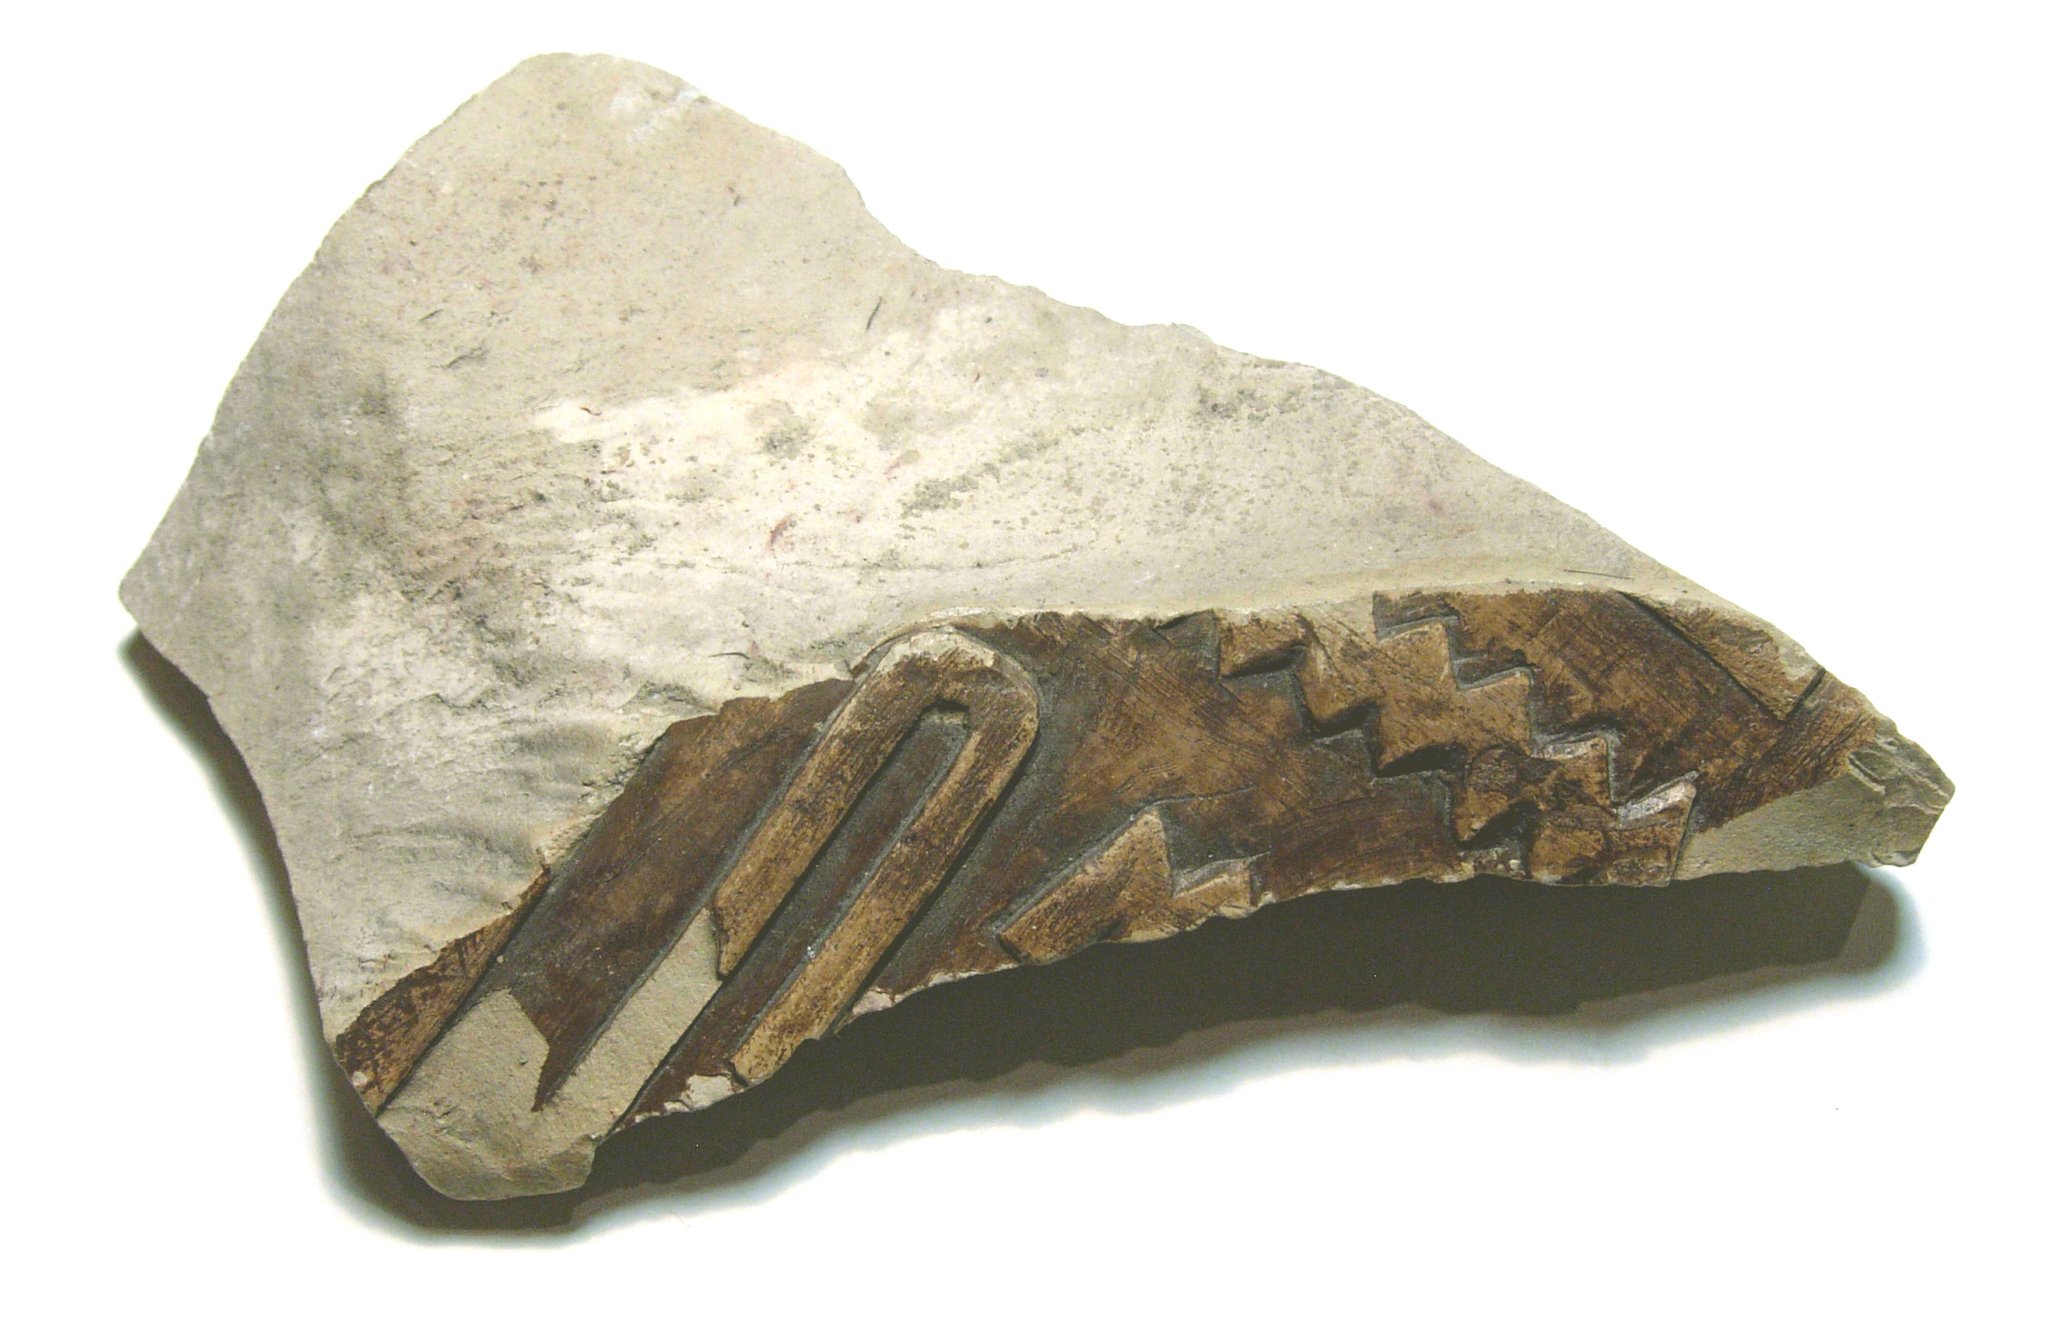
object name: relief, tomb of nespekashuty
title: Raised relief fragment with hieroglyphs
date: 664-610 BCE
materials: limestone, varnish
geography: egypt